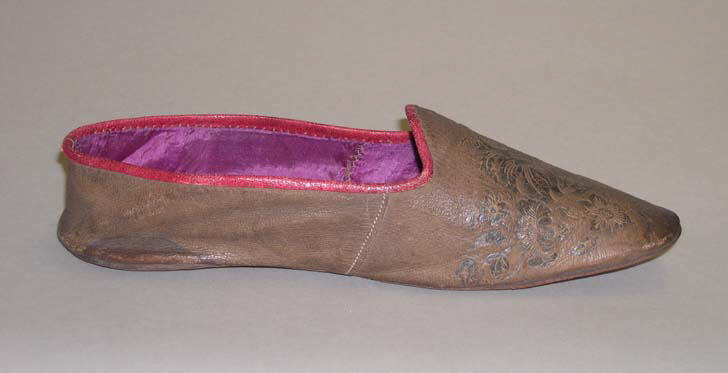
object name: shoe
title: Shoes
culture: american or european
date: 1830-1840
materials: leather